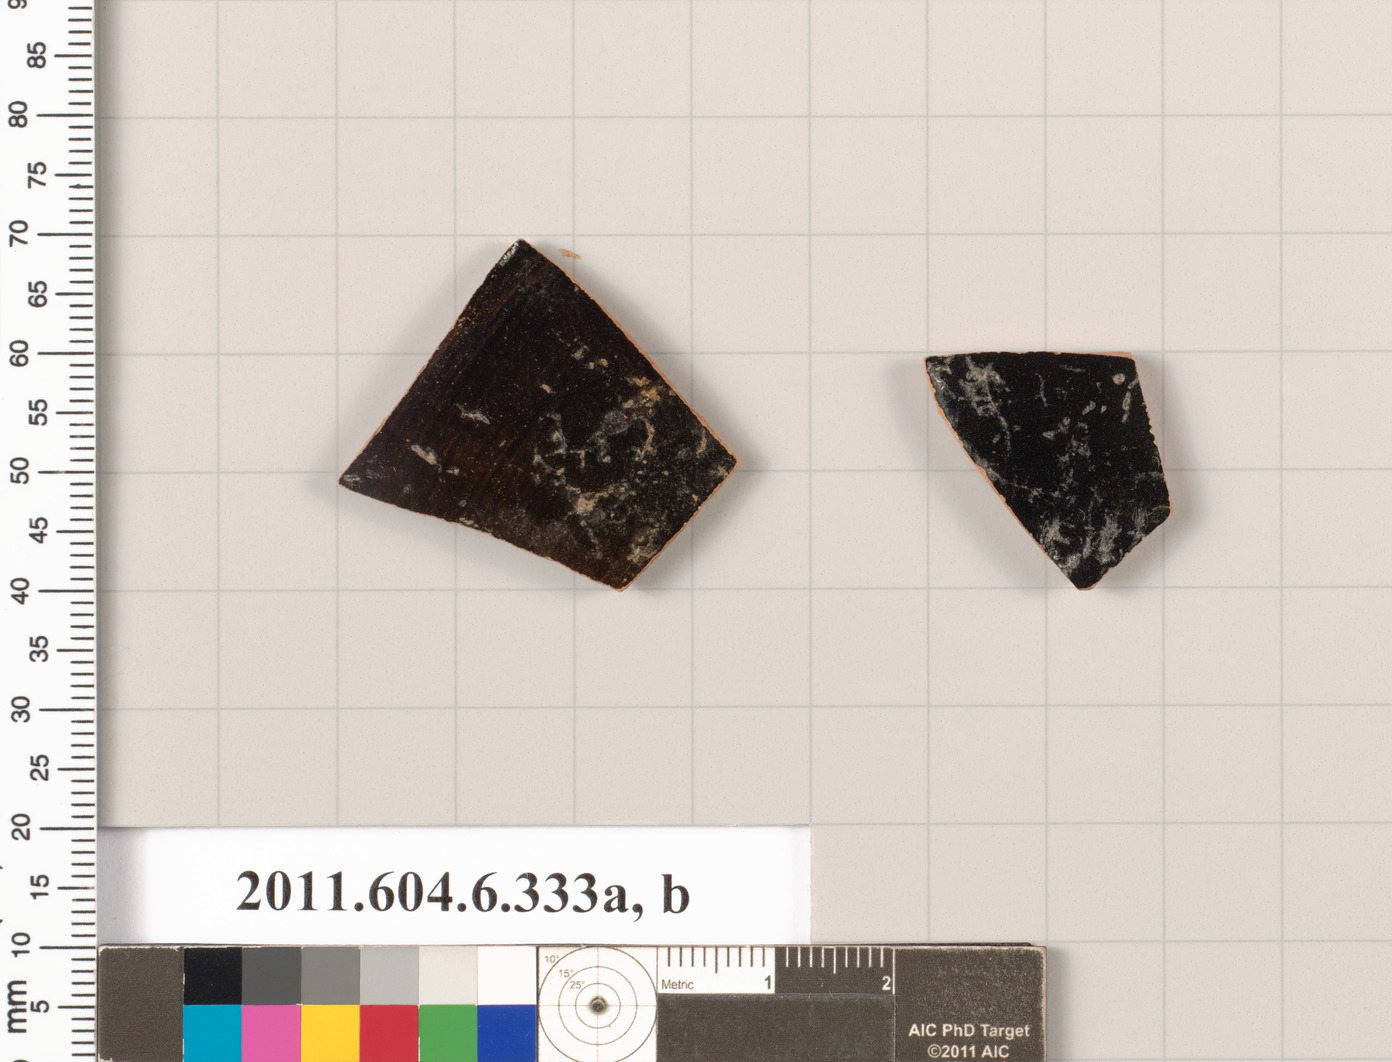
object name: unidentified shape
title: Terracotta fragments of unidentified shapes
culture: greek, attic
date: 600-401 BCE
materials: terracotta